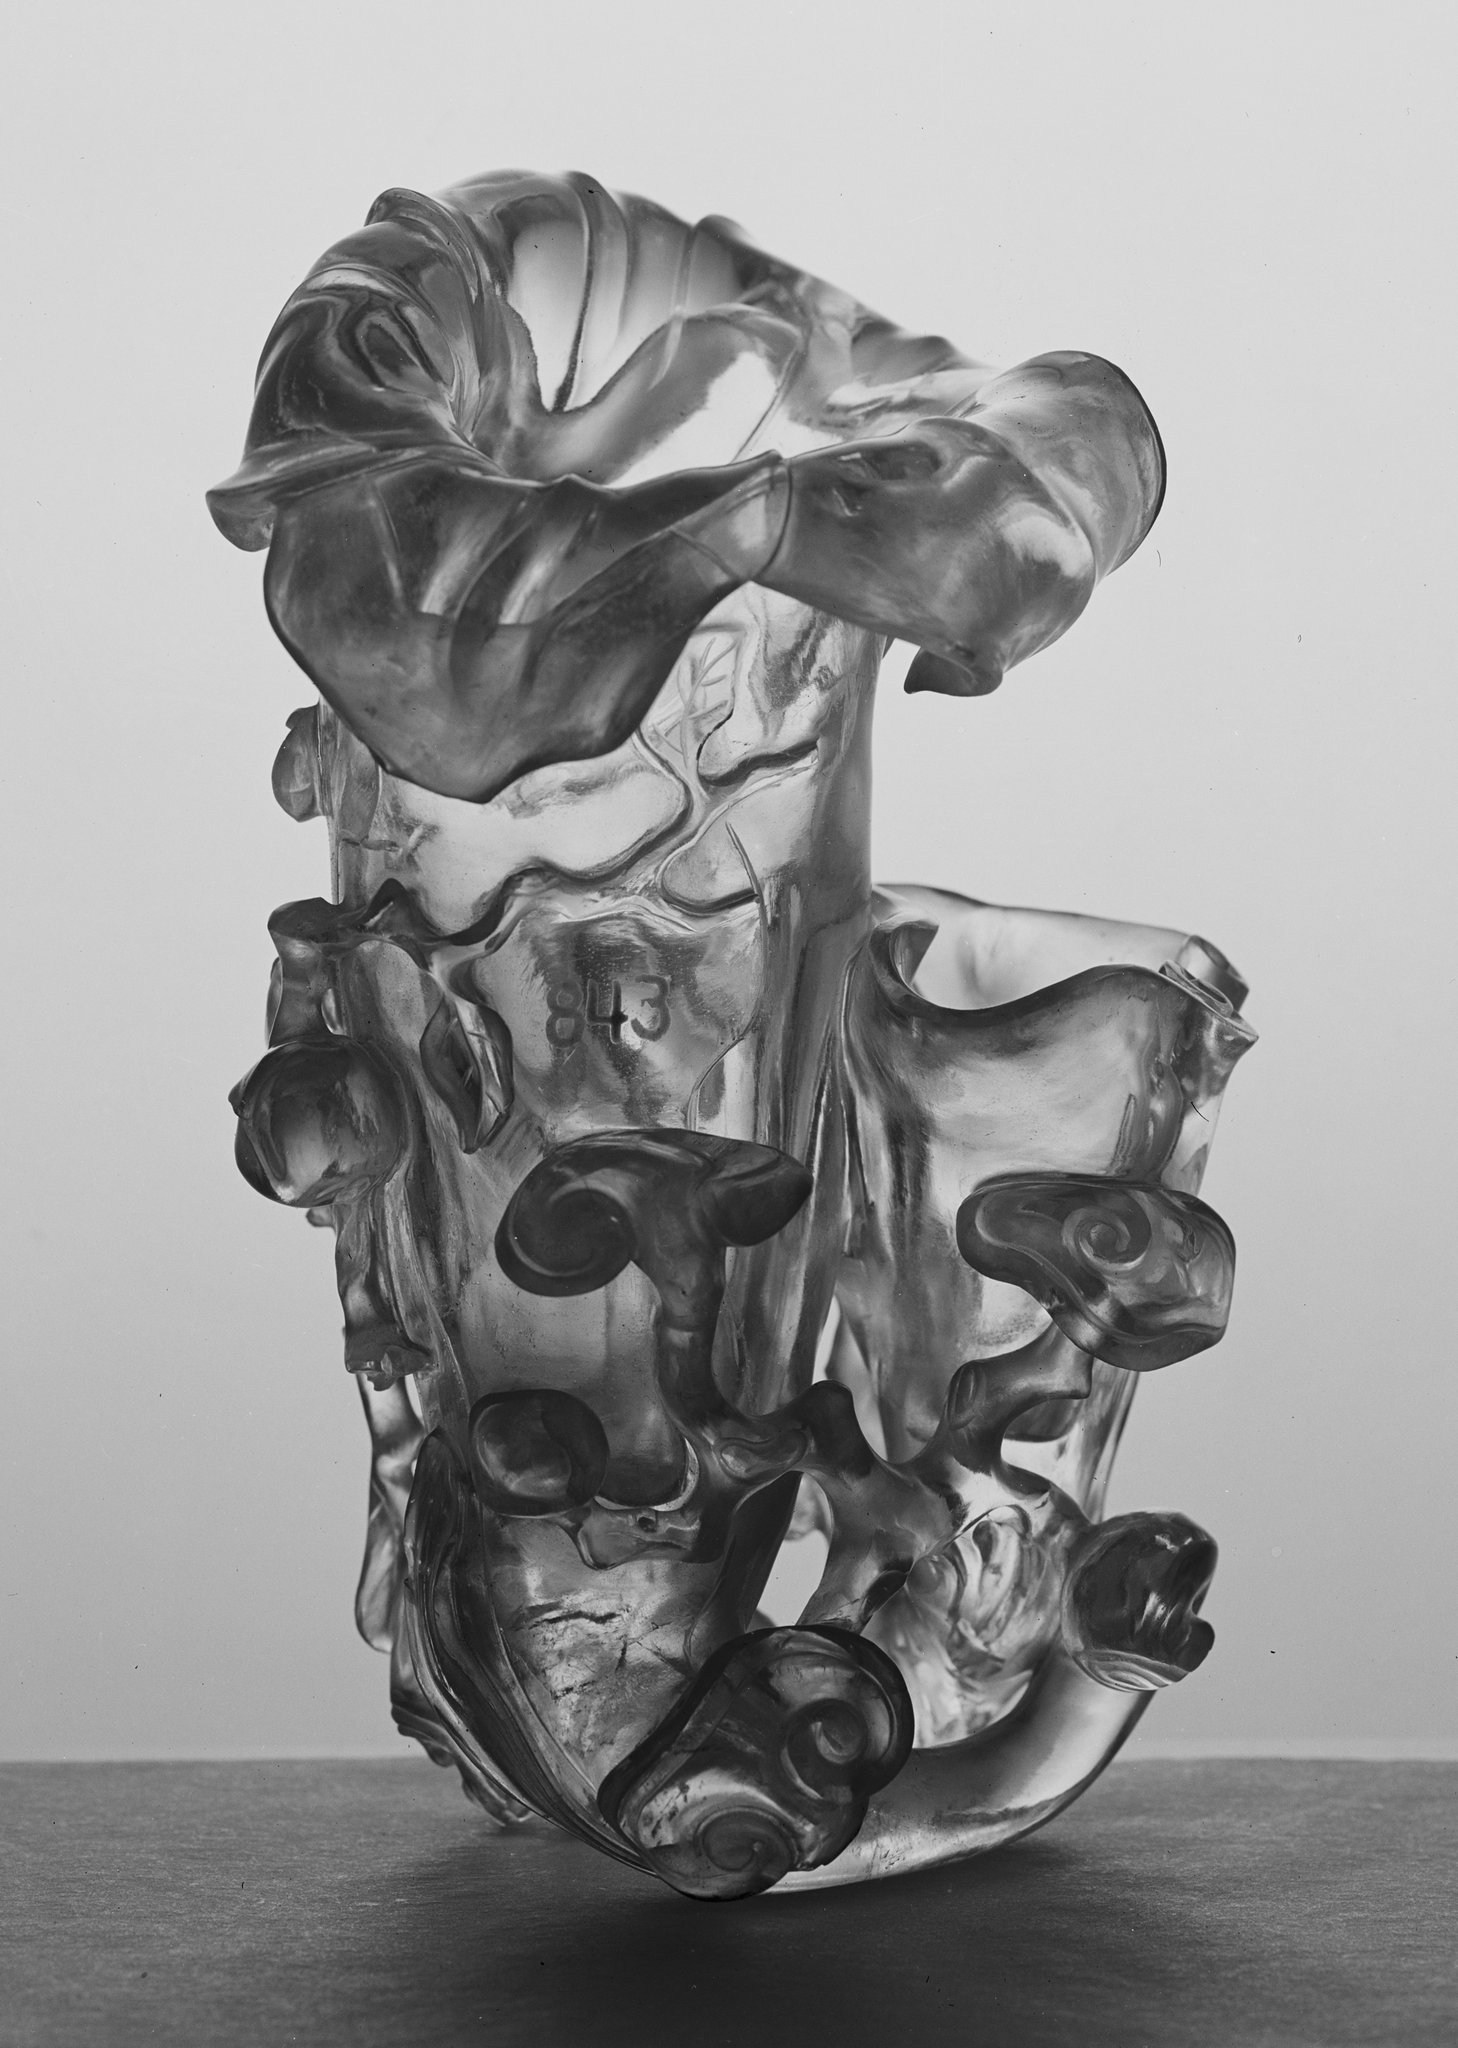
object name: double vase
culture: chinese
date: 1701-1800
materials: quartz